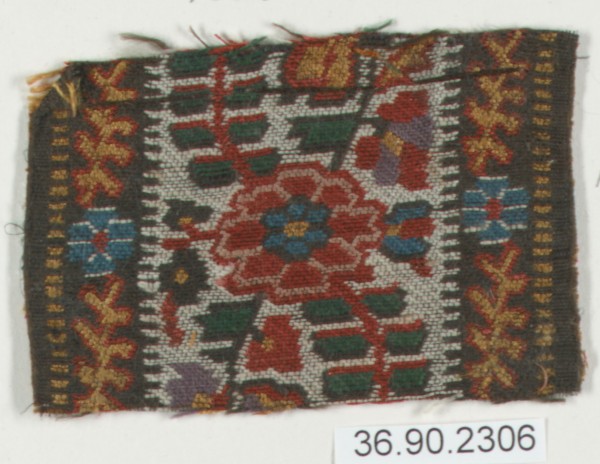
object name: border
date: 1801-1900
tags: flowers